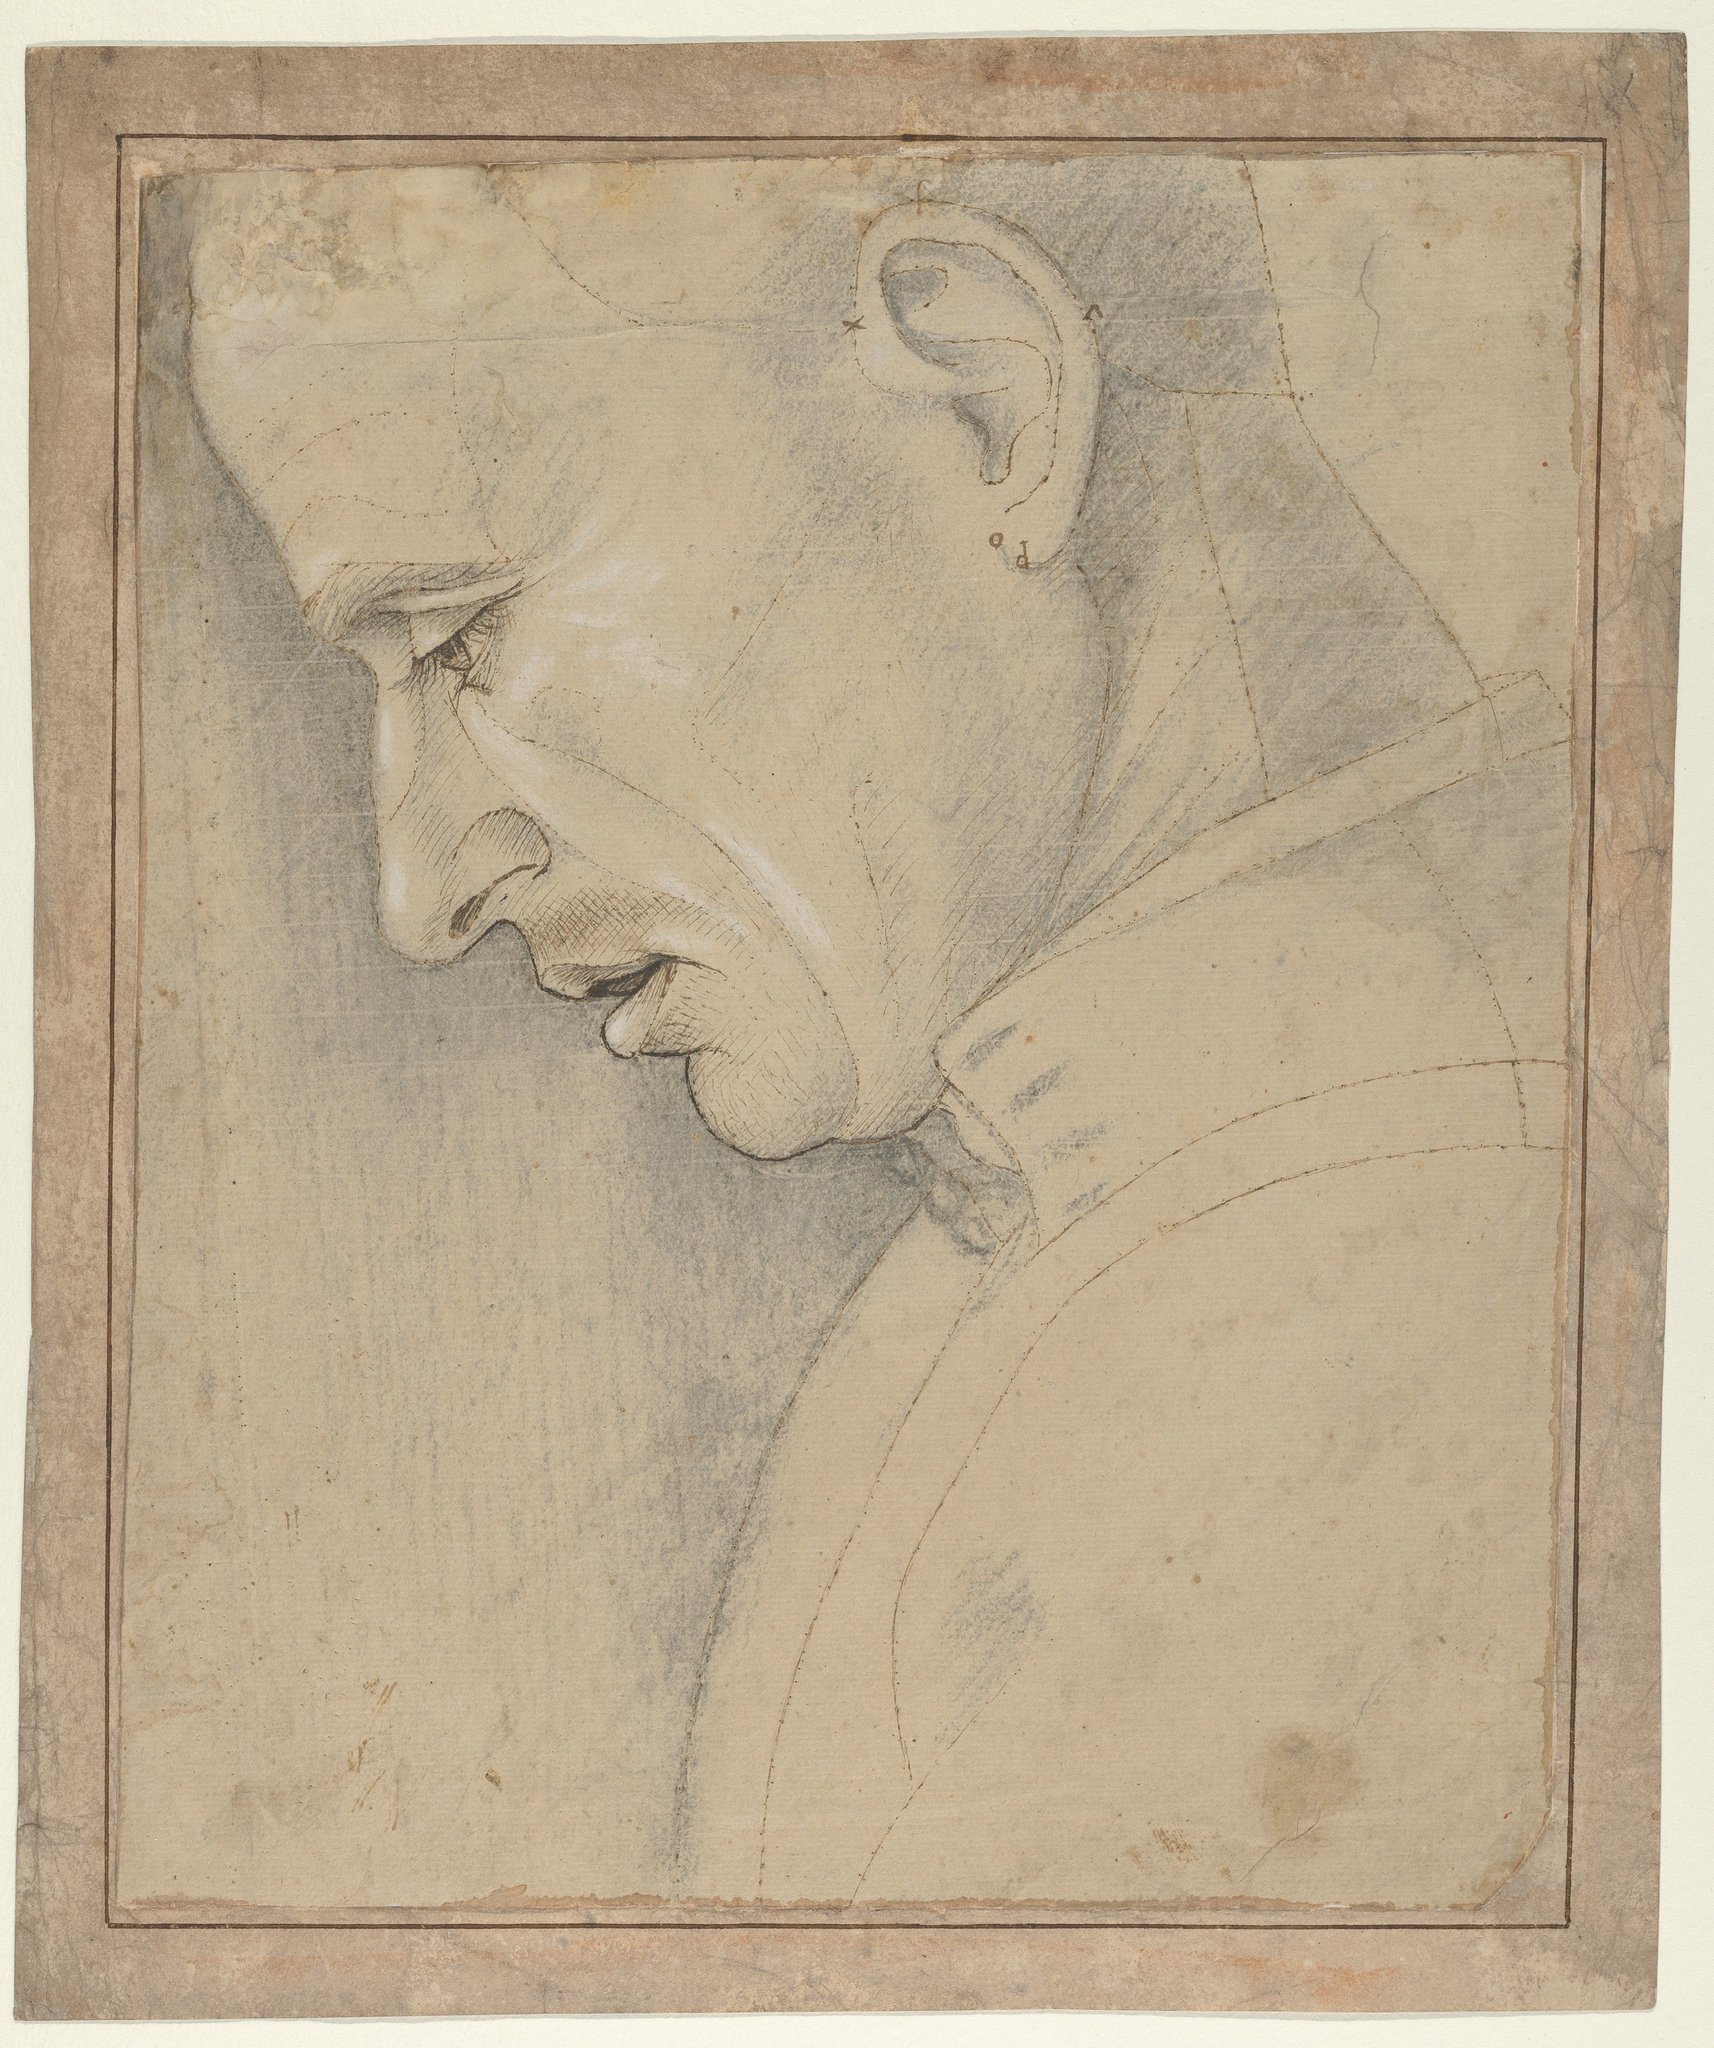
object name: drawing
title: Head of a Man in Profile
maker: luca signorelli (luca d'egidio di luca di ventura)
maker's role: artist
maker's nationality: italian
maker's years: 1470-1523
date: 1490-1499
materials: chalk, ink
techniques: heightening, pen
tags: heads,men,profiles